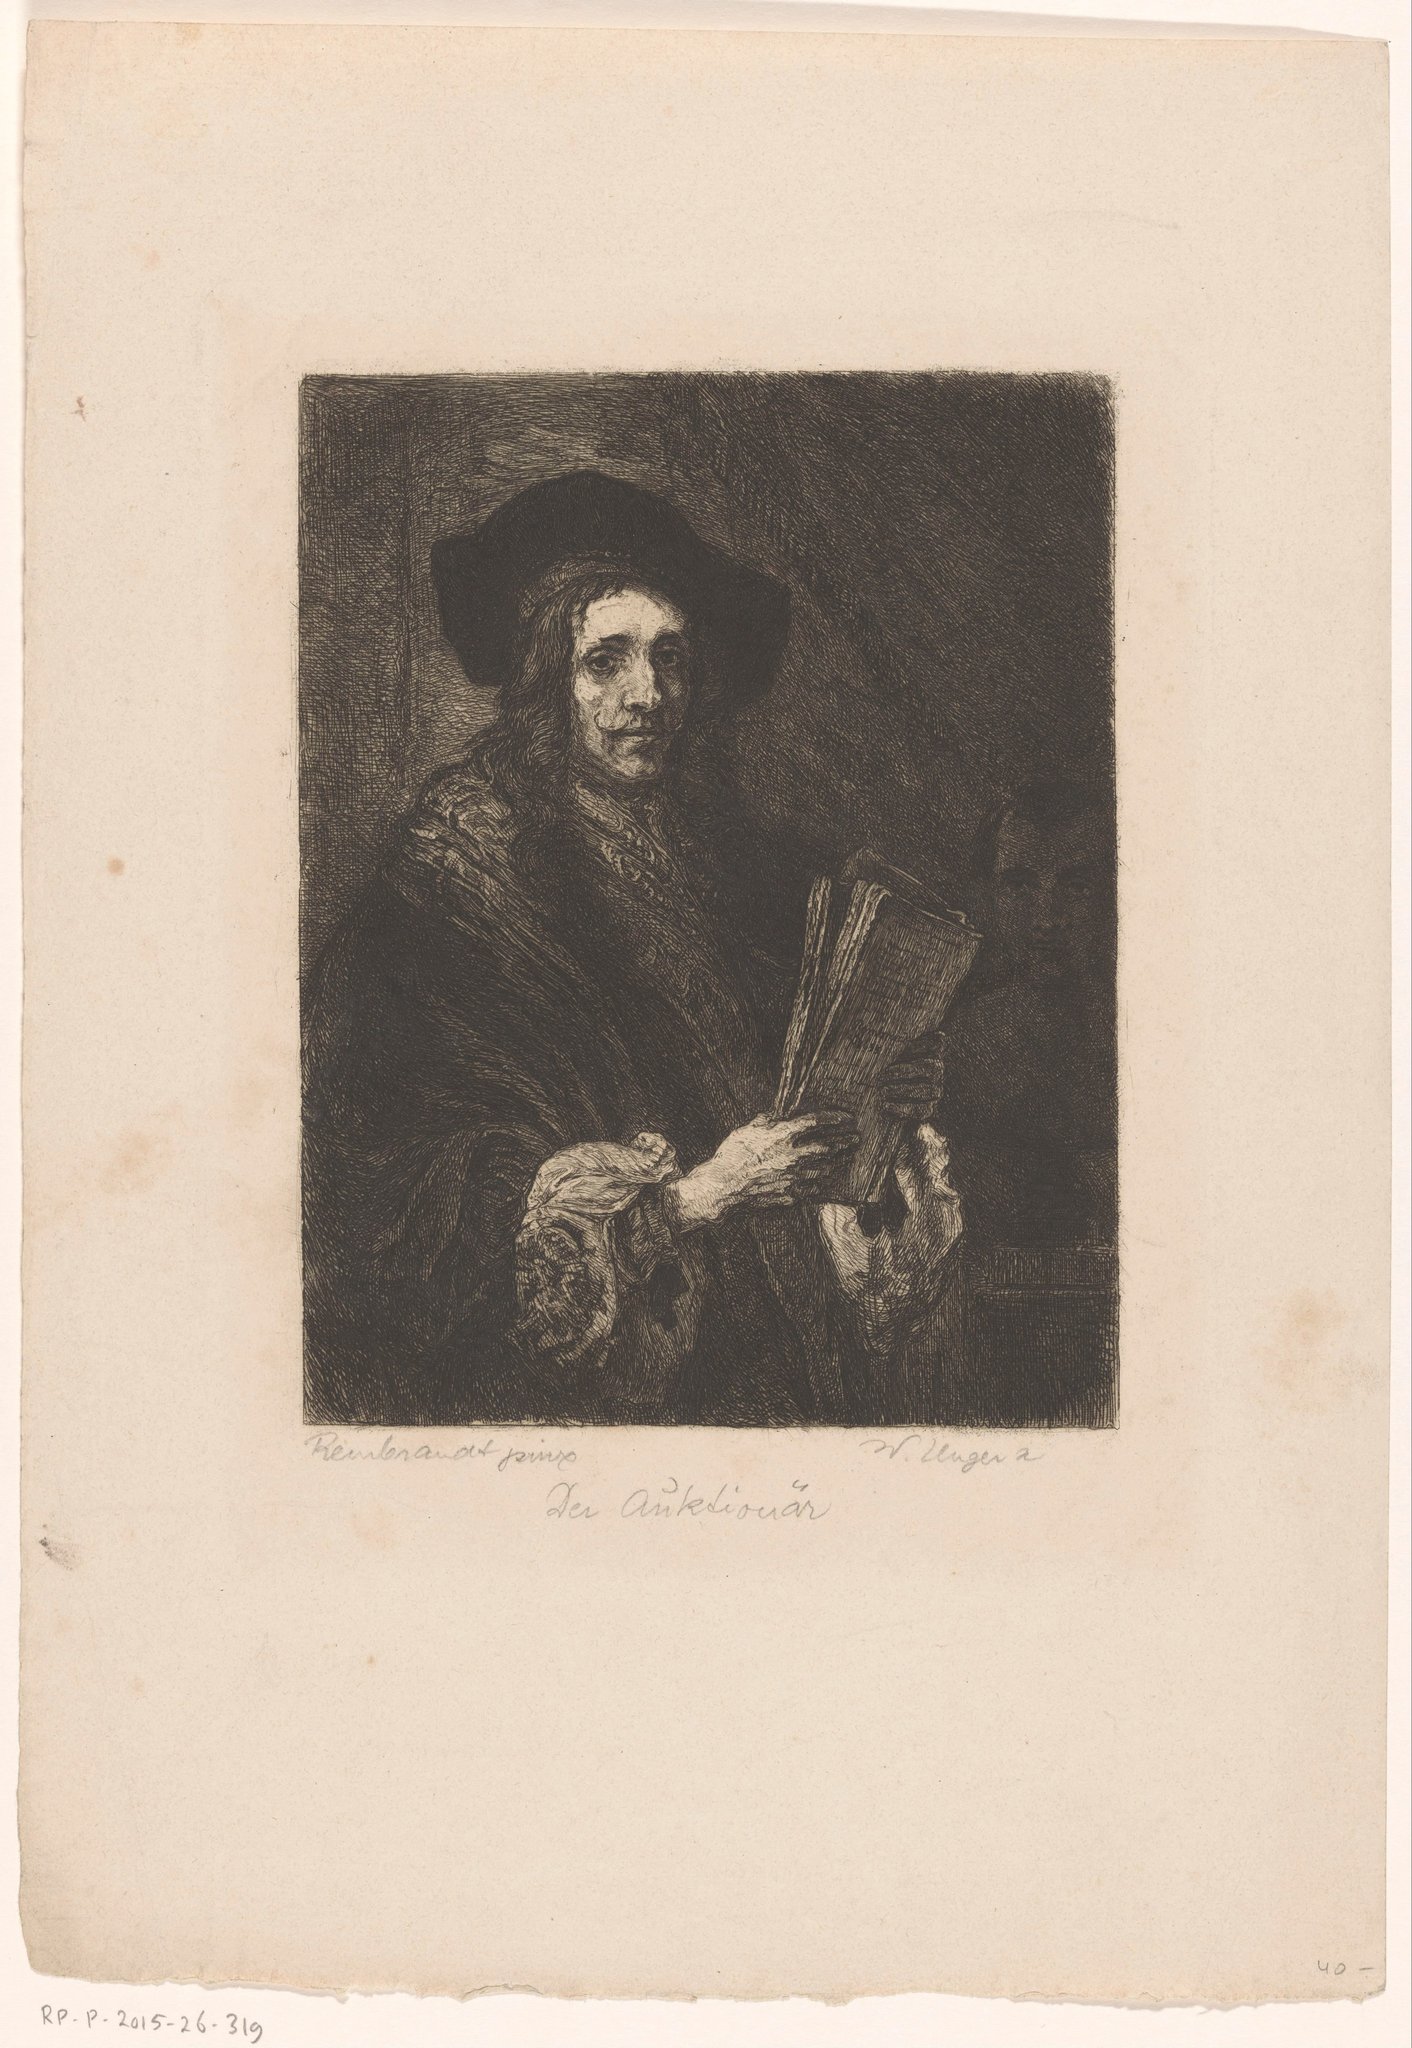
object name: print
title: Der Auktionär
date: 1847-1932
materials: paper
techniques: etching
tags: scholar, philosopher, anonymous historical person portrayed alone, head-gear: beret, art sale, auction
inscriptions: collector's mark: Lugt 2228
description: Portret van een man ten halven lijve met een baret en een snor, een manuscript in zijn handen. Op het manuscript is te lezen "Rembrandt f. 1658".